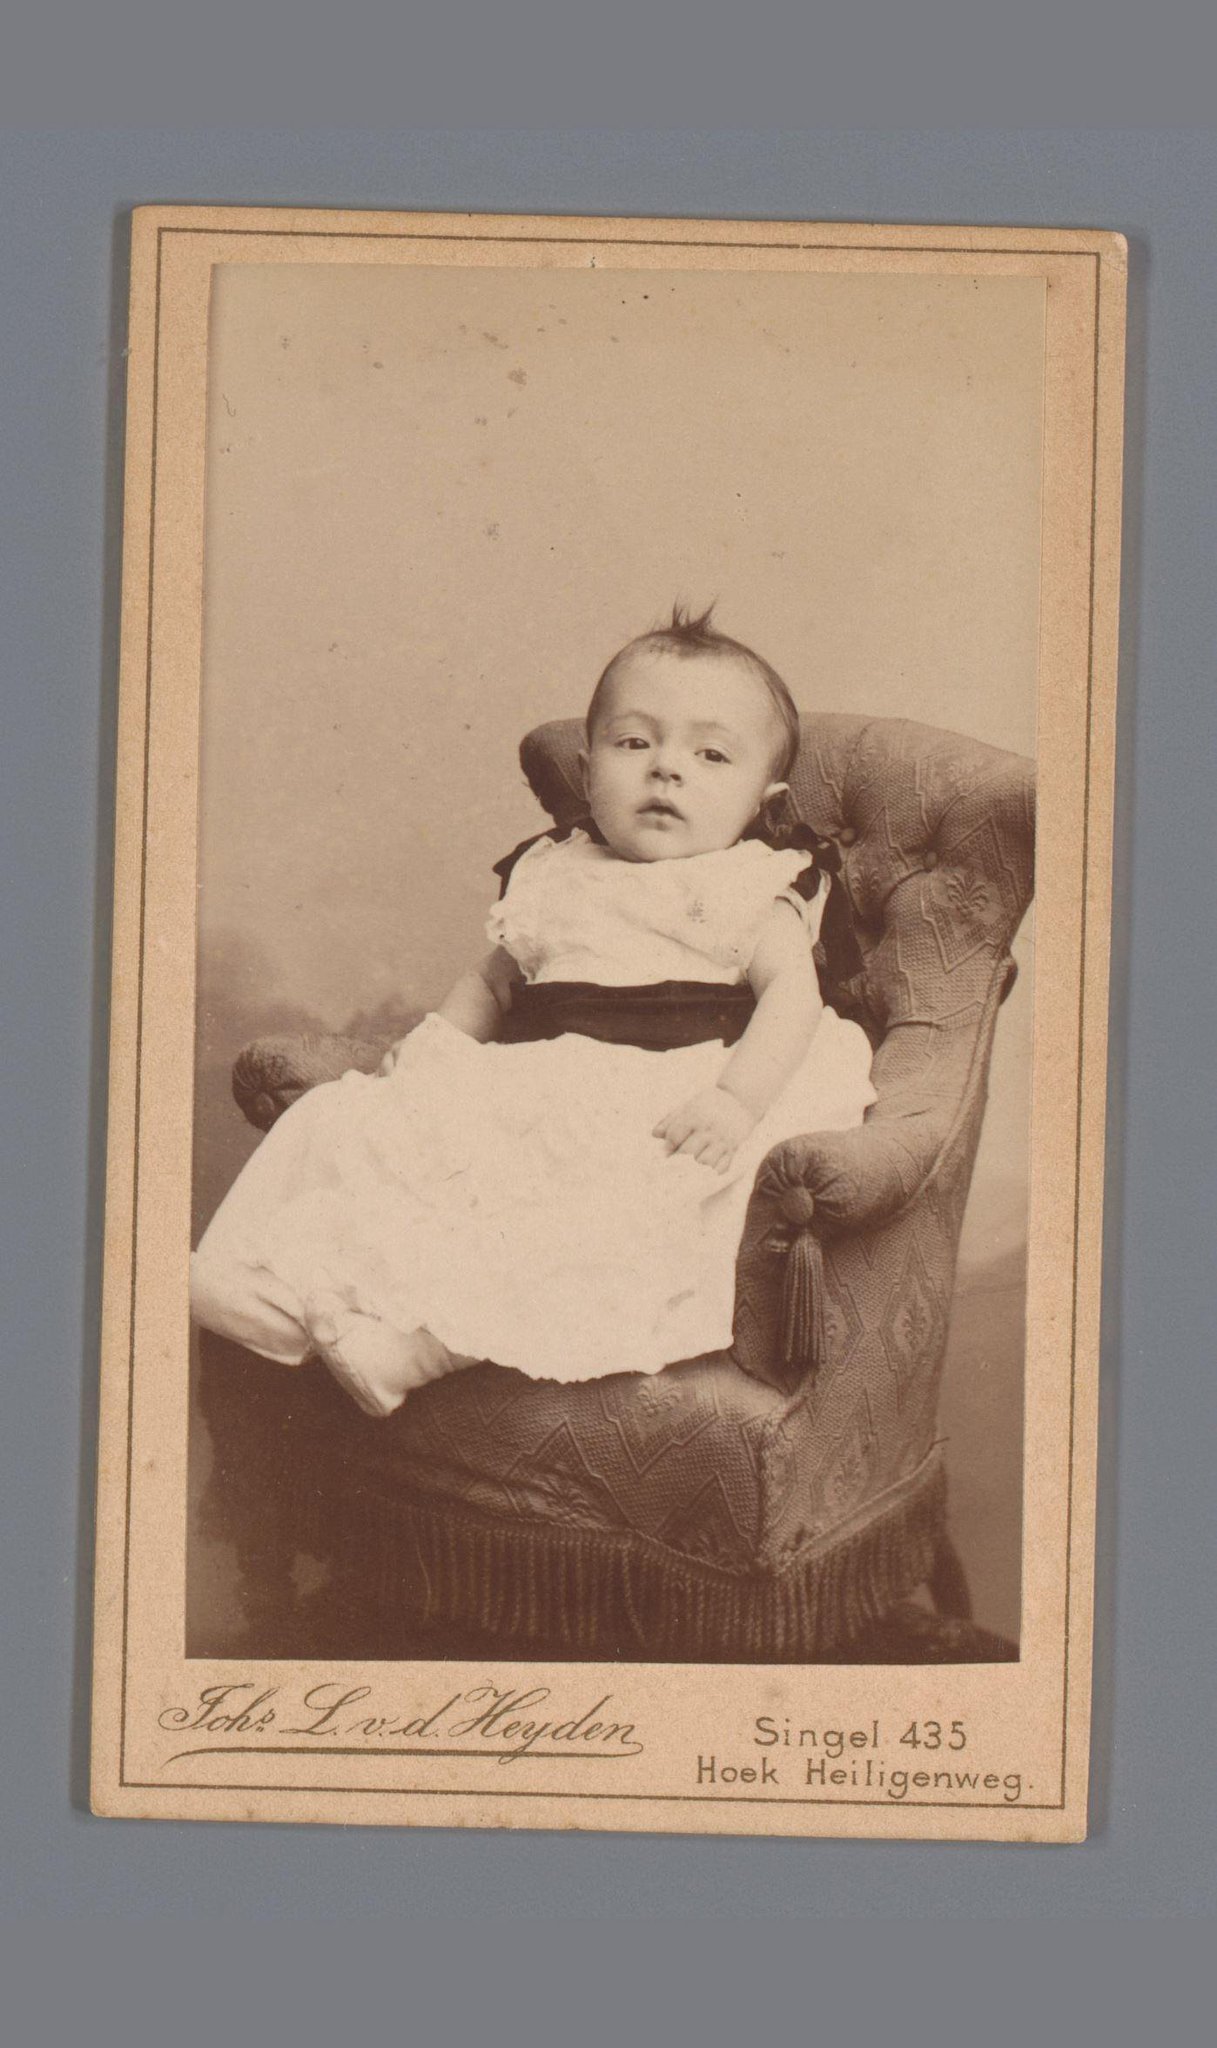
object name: carte de visite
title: Portret van een onbekende baby in een stoel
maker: johannes leonardus van der heijden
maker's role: fotograaf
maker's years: 1856-1937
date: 1875-1900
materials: cardboard, paper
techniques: albumen print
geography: amsterdam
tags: historical persons, infant, baby, chair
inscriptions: inscription: ‘Johs. L. v.d. Heijden/ AMSTERDAM Singel 435.’